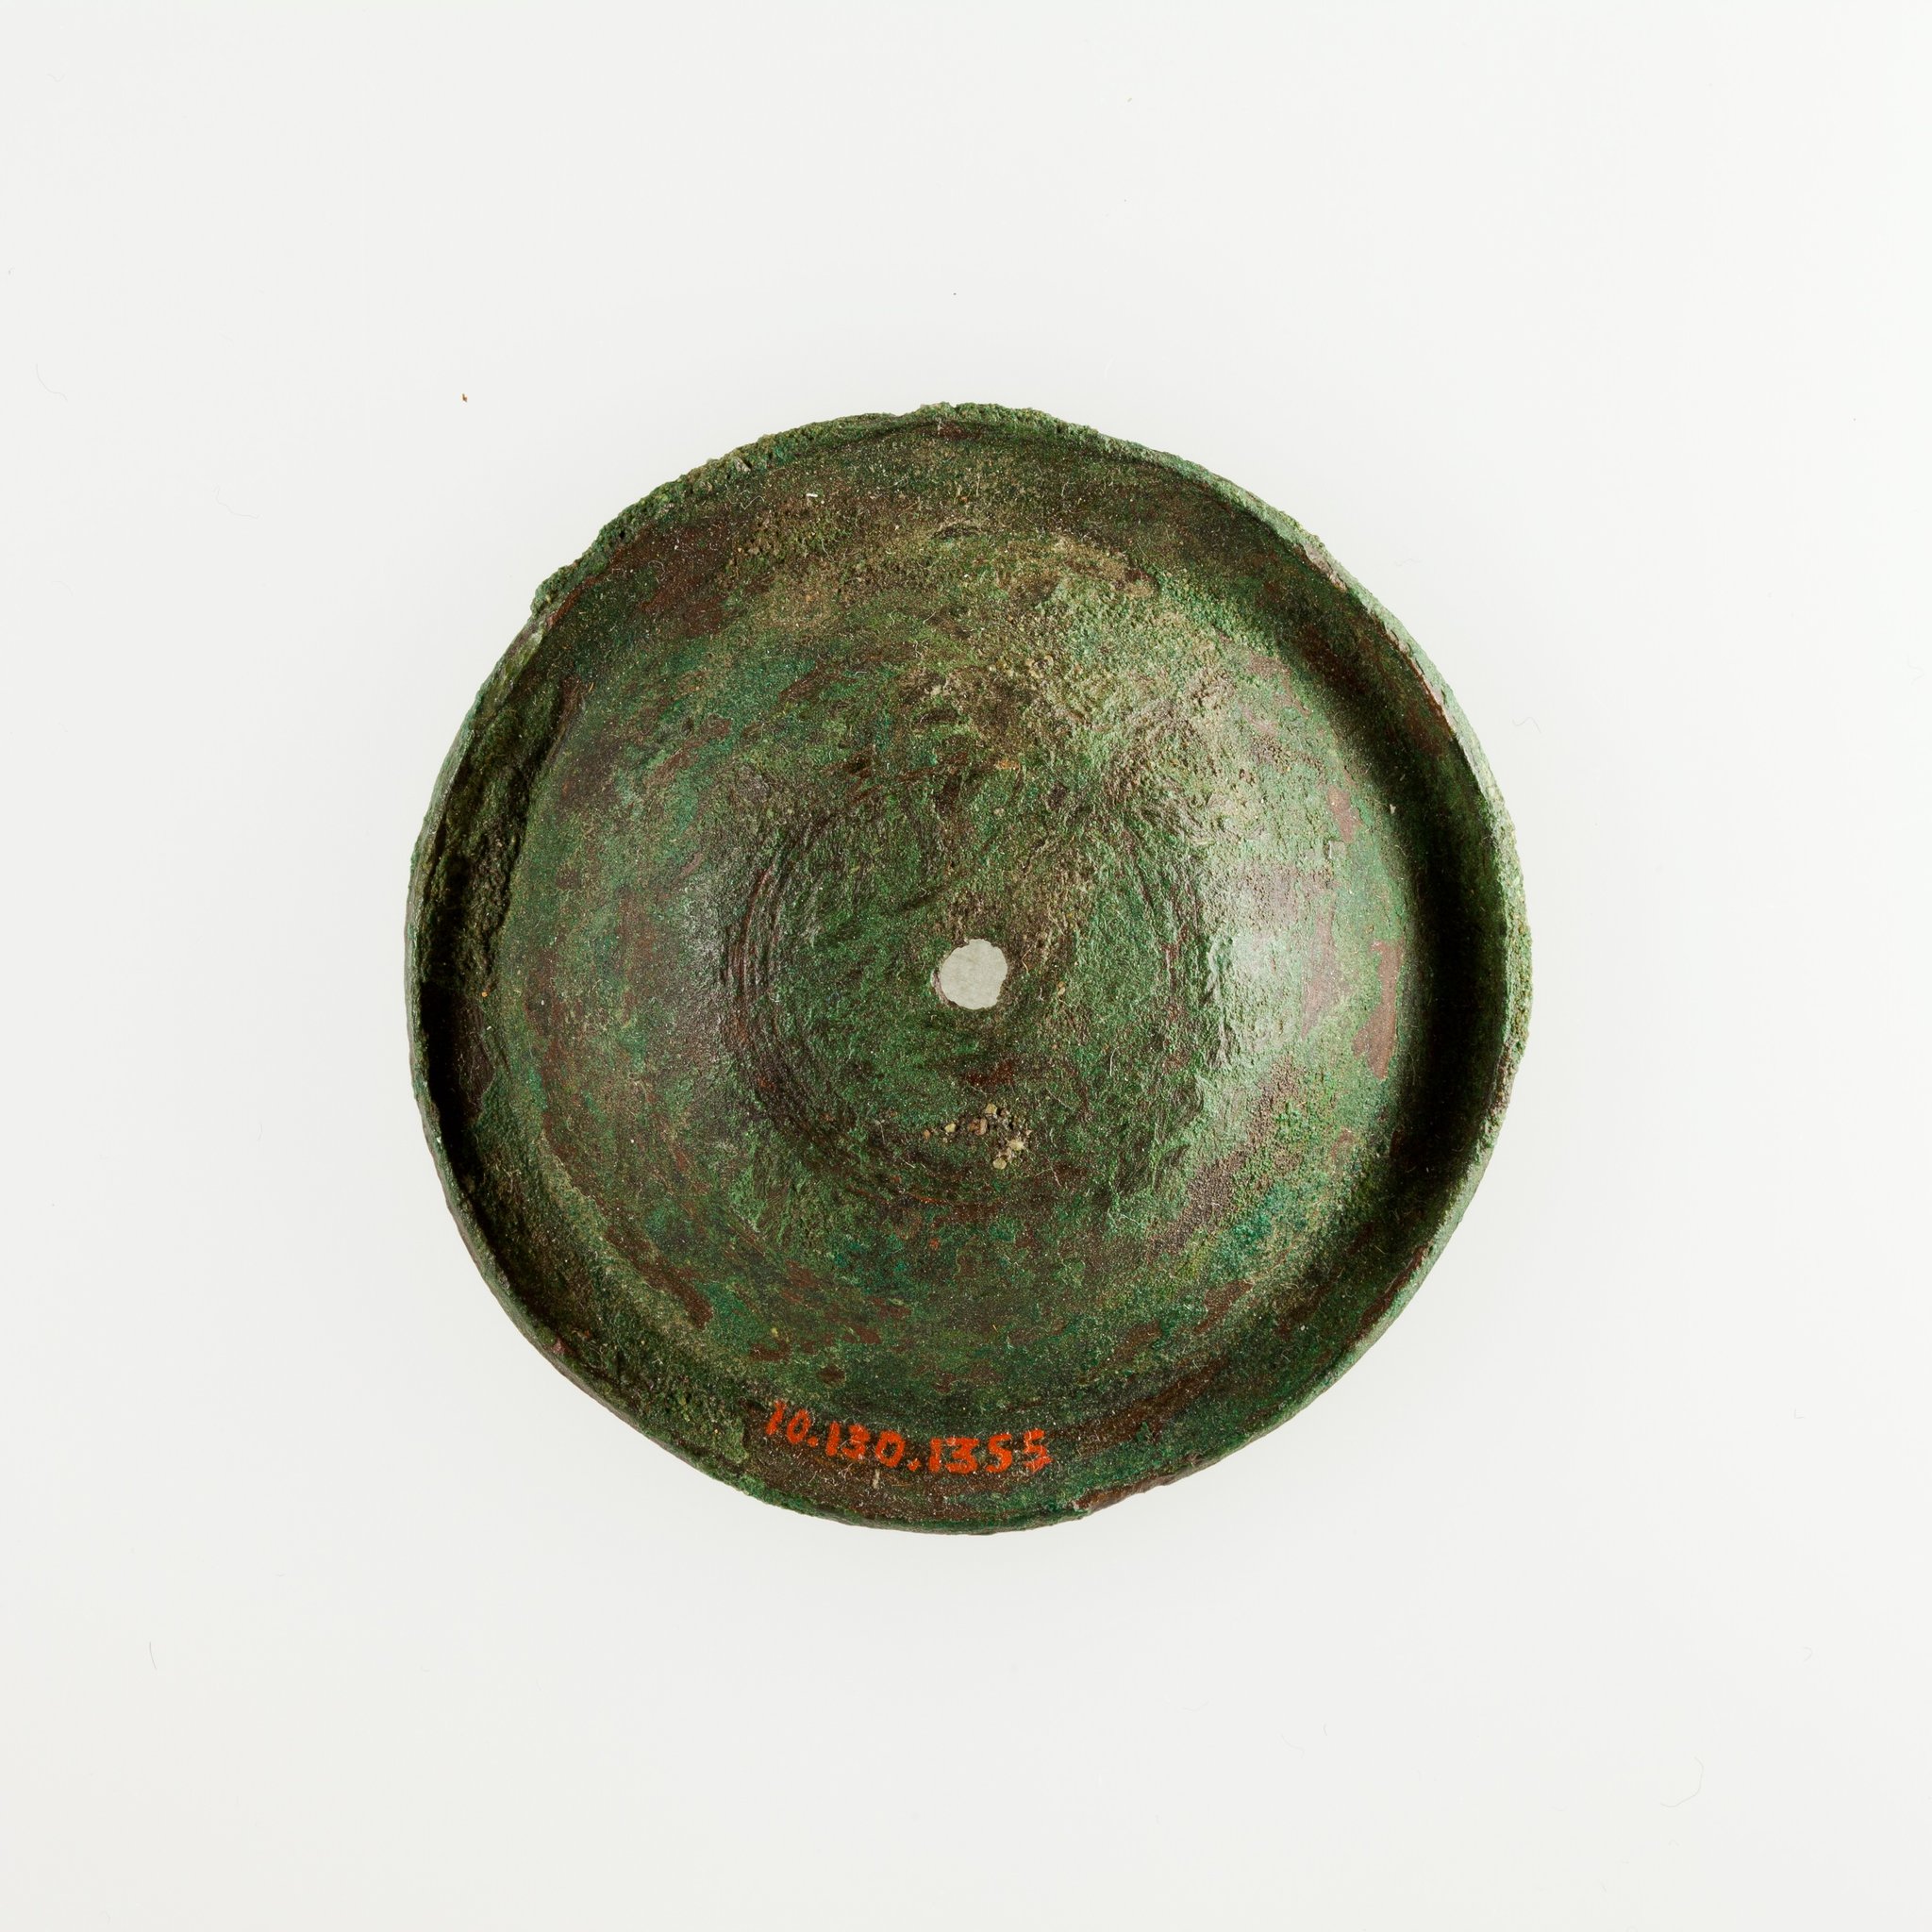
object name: music, cymbal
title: Cymbal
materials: copper alloy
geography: egypt